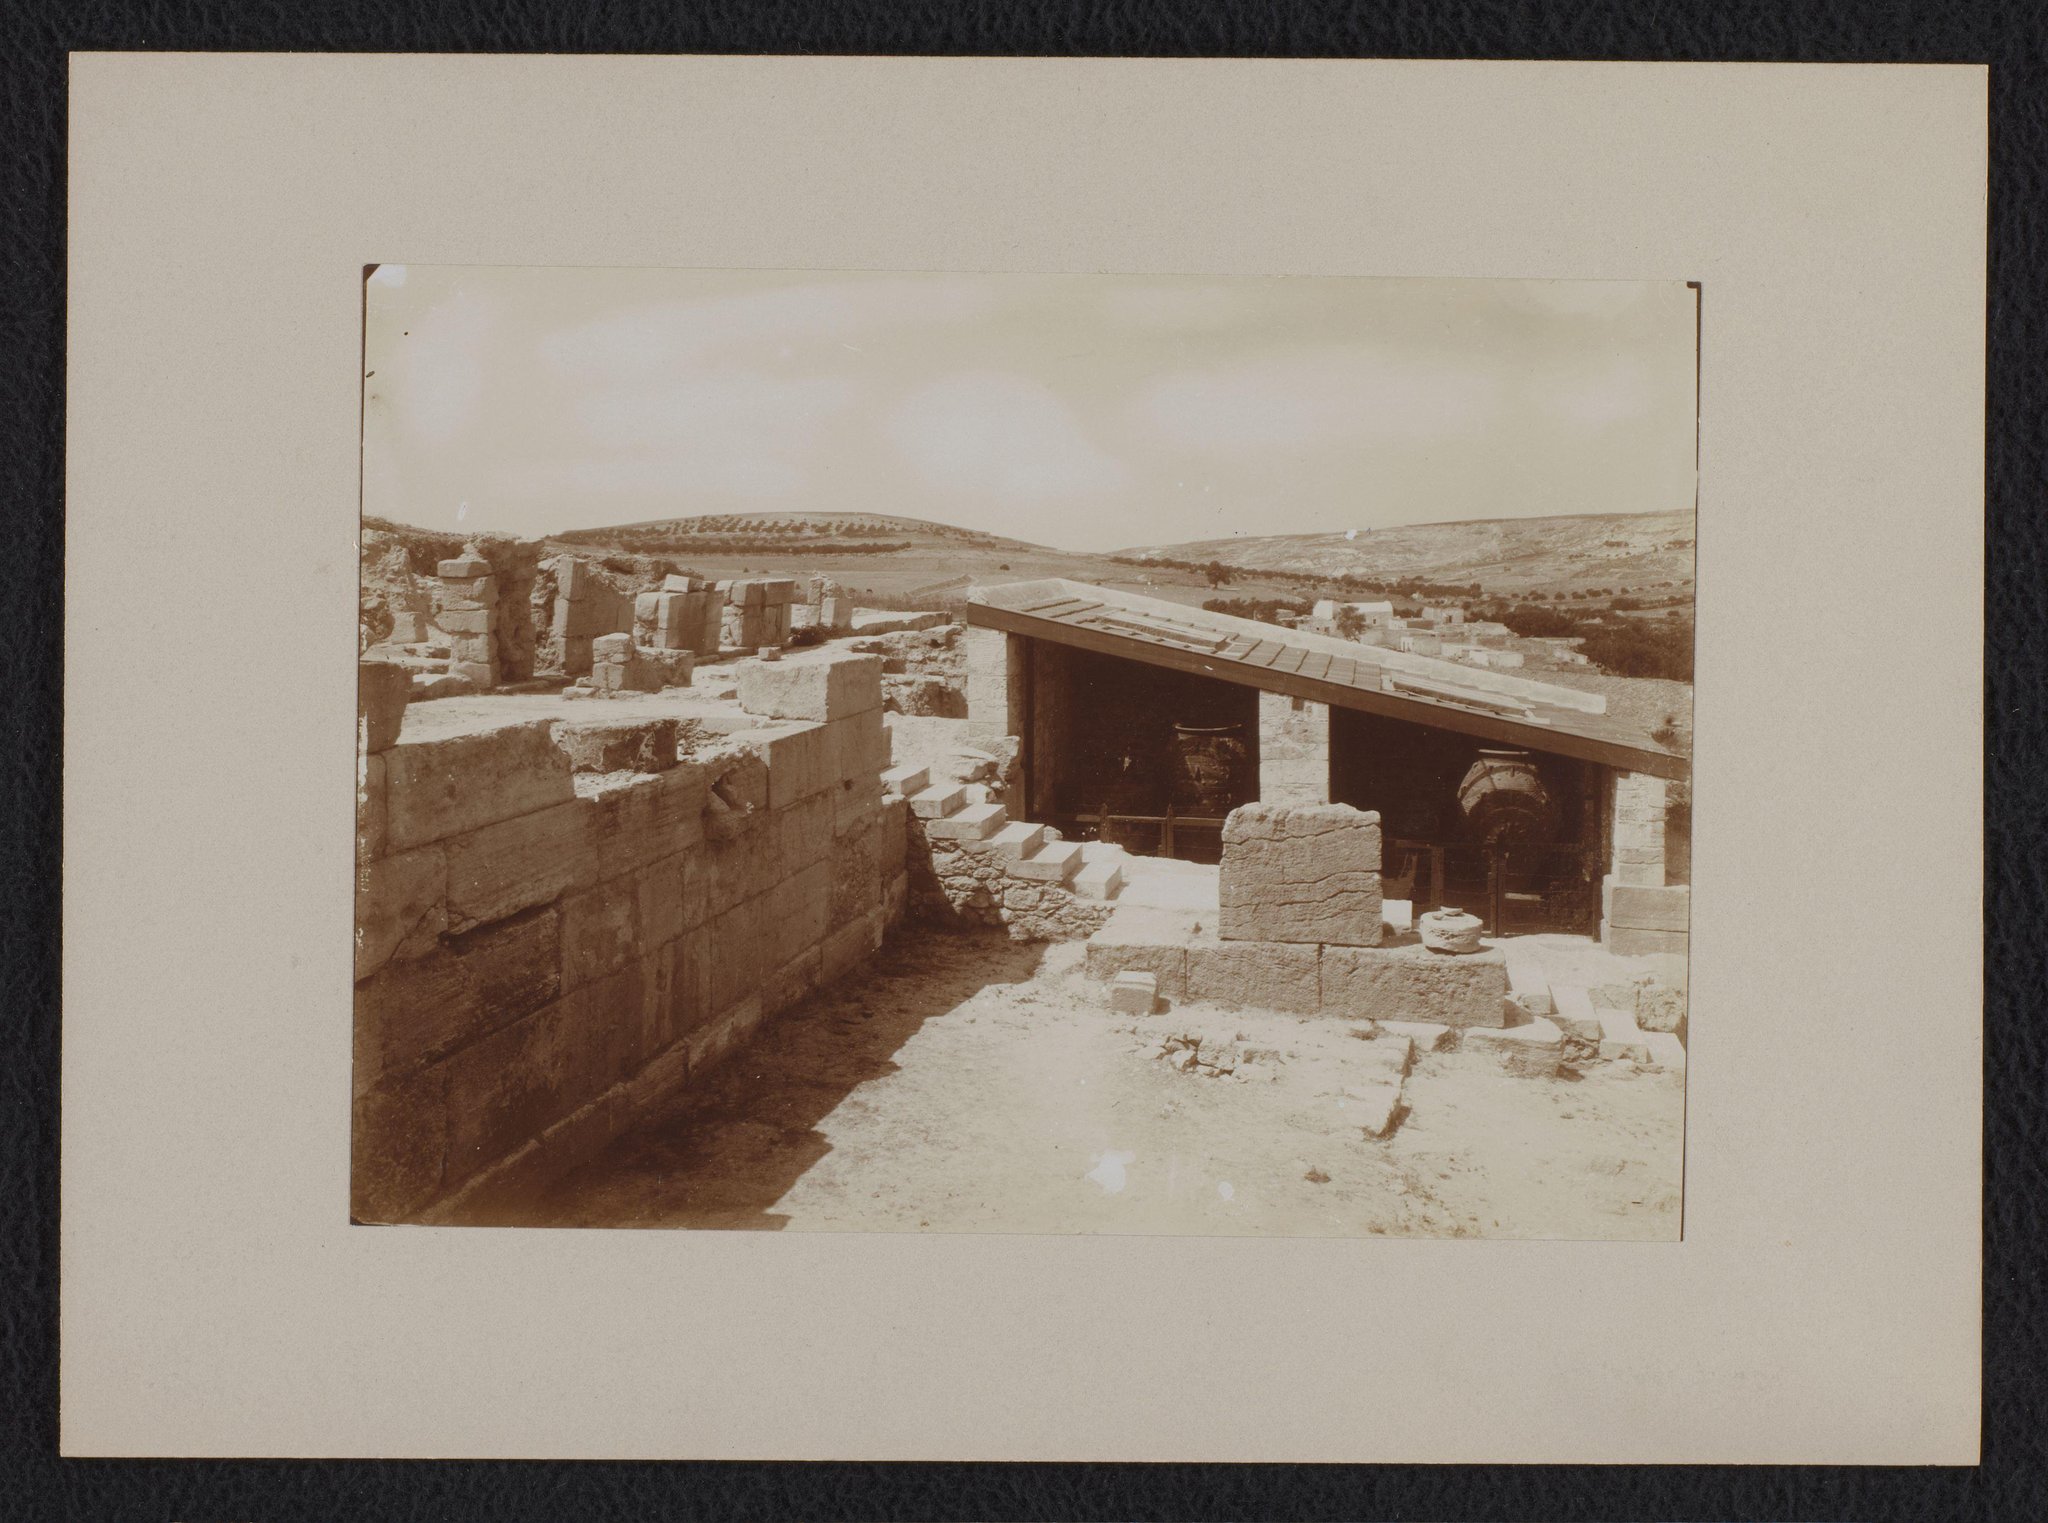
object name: photograph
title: Twee vazen (?) onder een afdak bij het Paleis van Knossos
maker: Anonymous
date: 1895-1915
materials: cardboard, paper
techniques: gelatin silver print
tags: knossós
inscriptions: annotation: ‘53. Kreta. Paleis te Cnossos.’